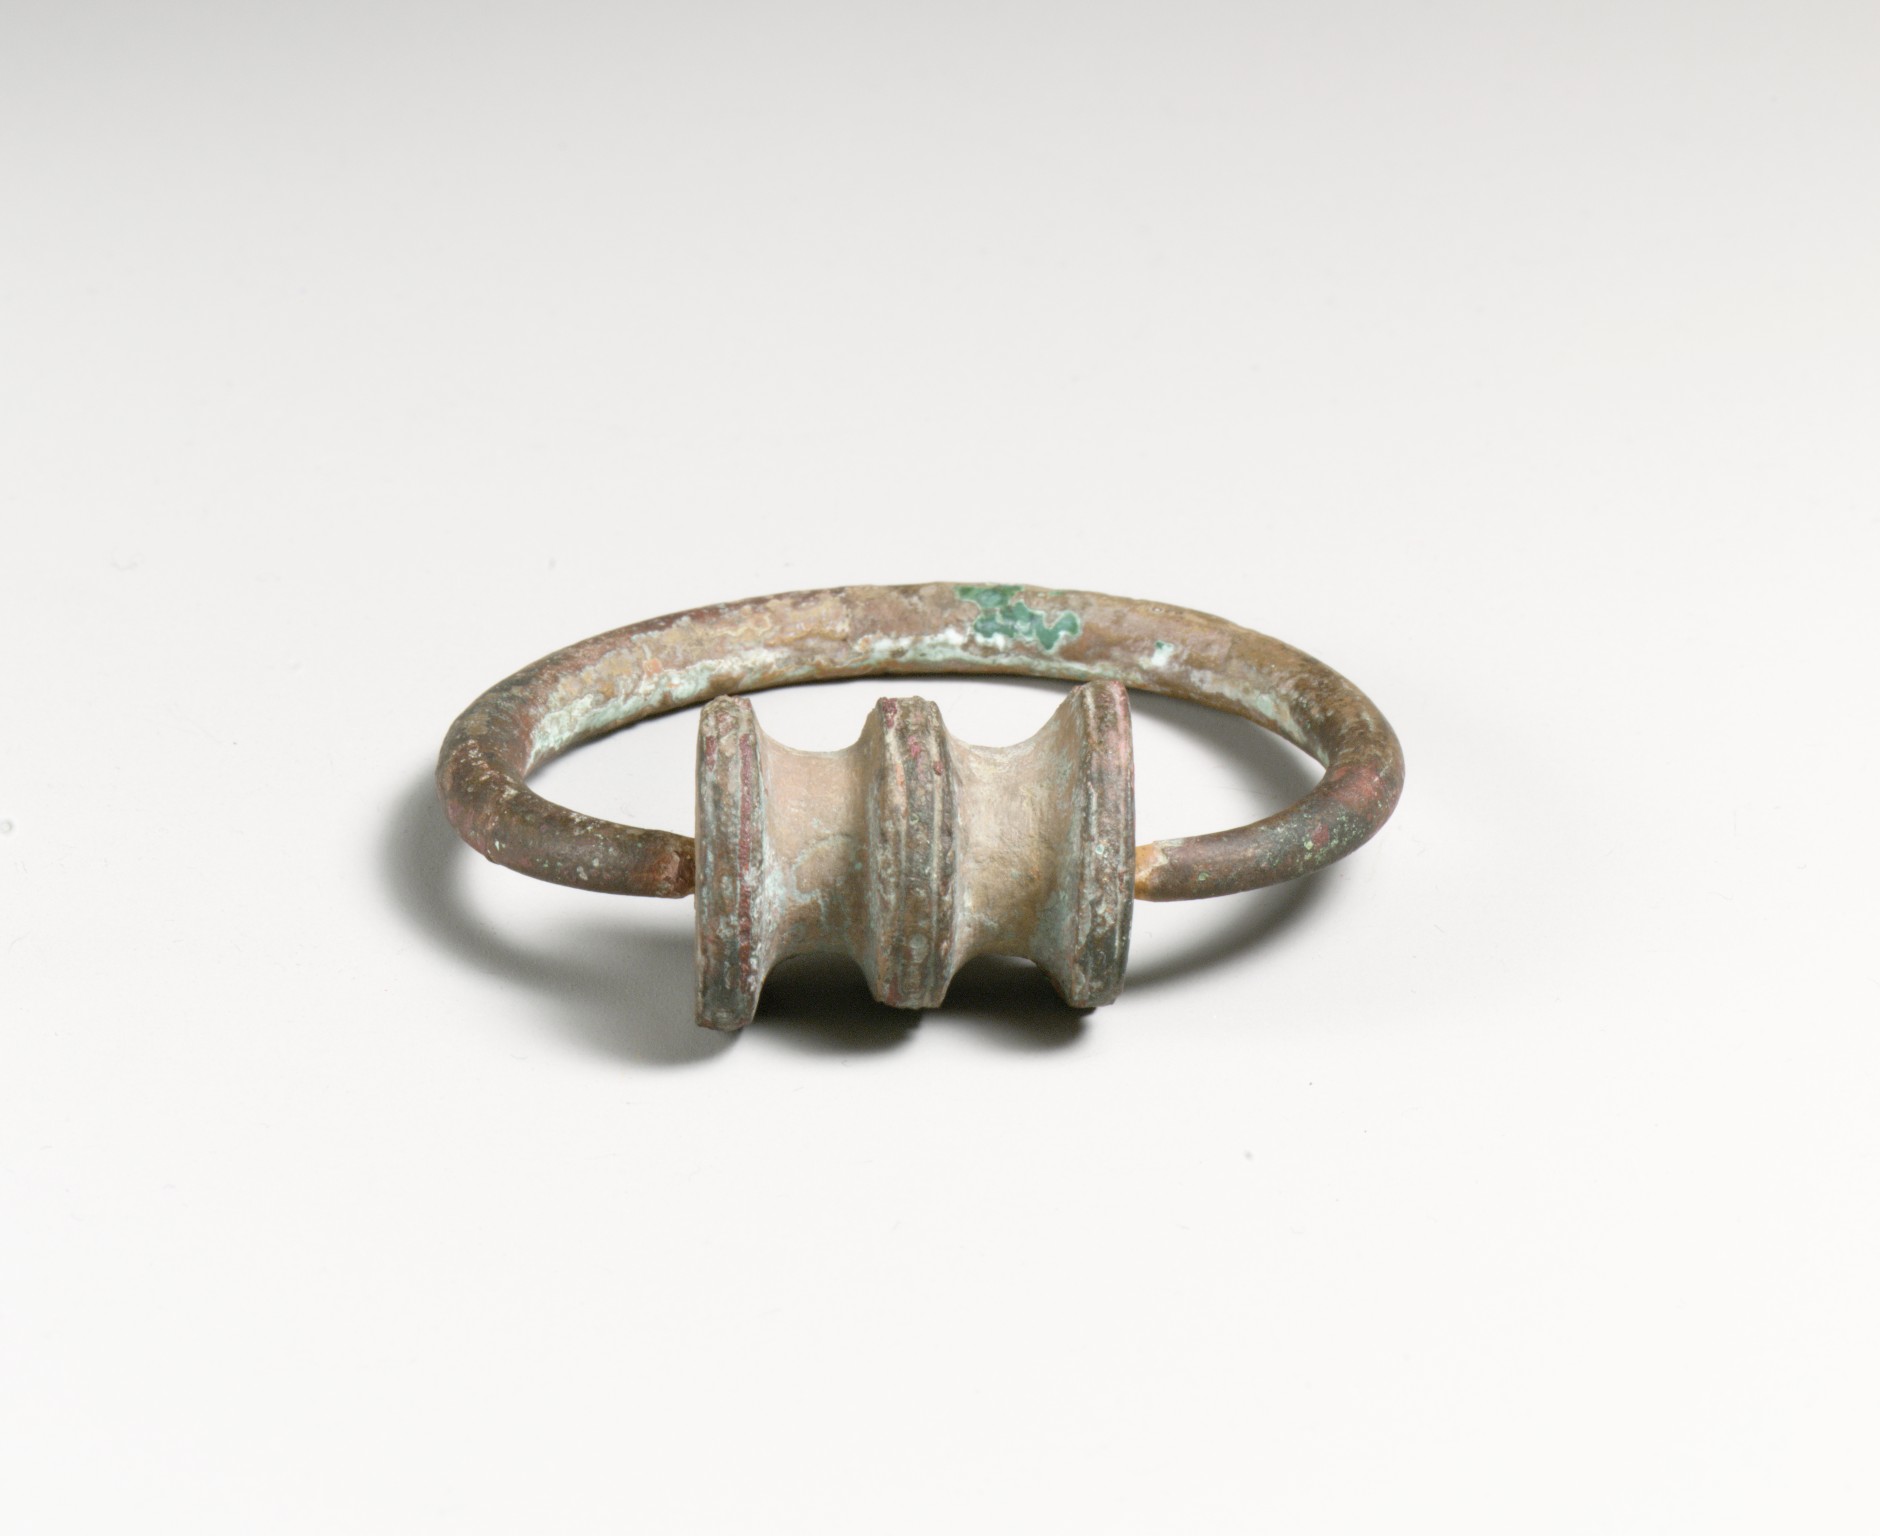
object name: handle of a bowl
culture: cypriot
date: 3900 BCE-100 CE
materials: bronze